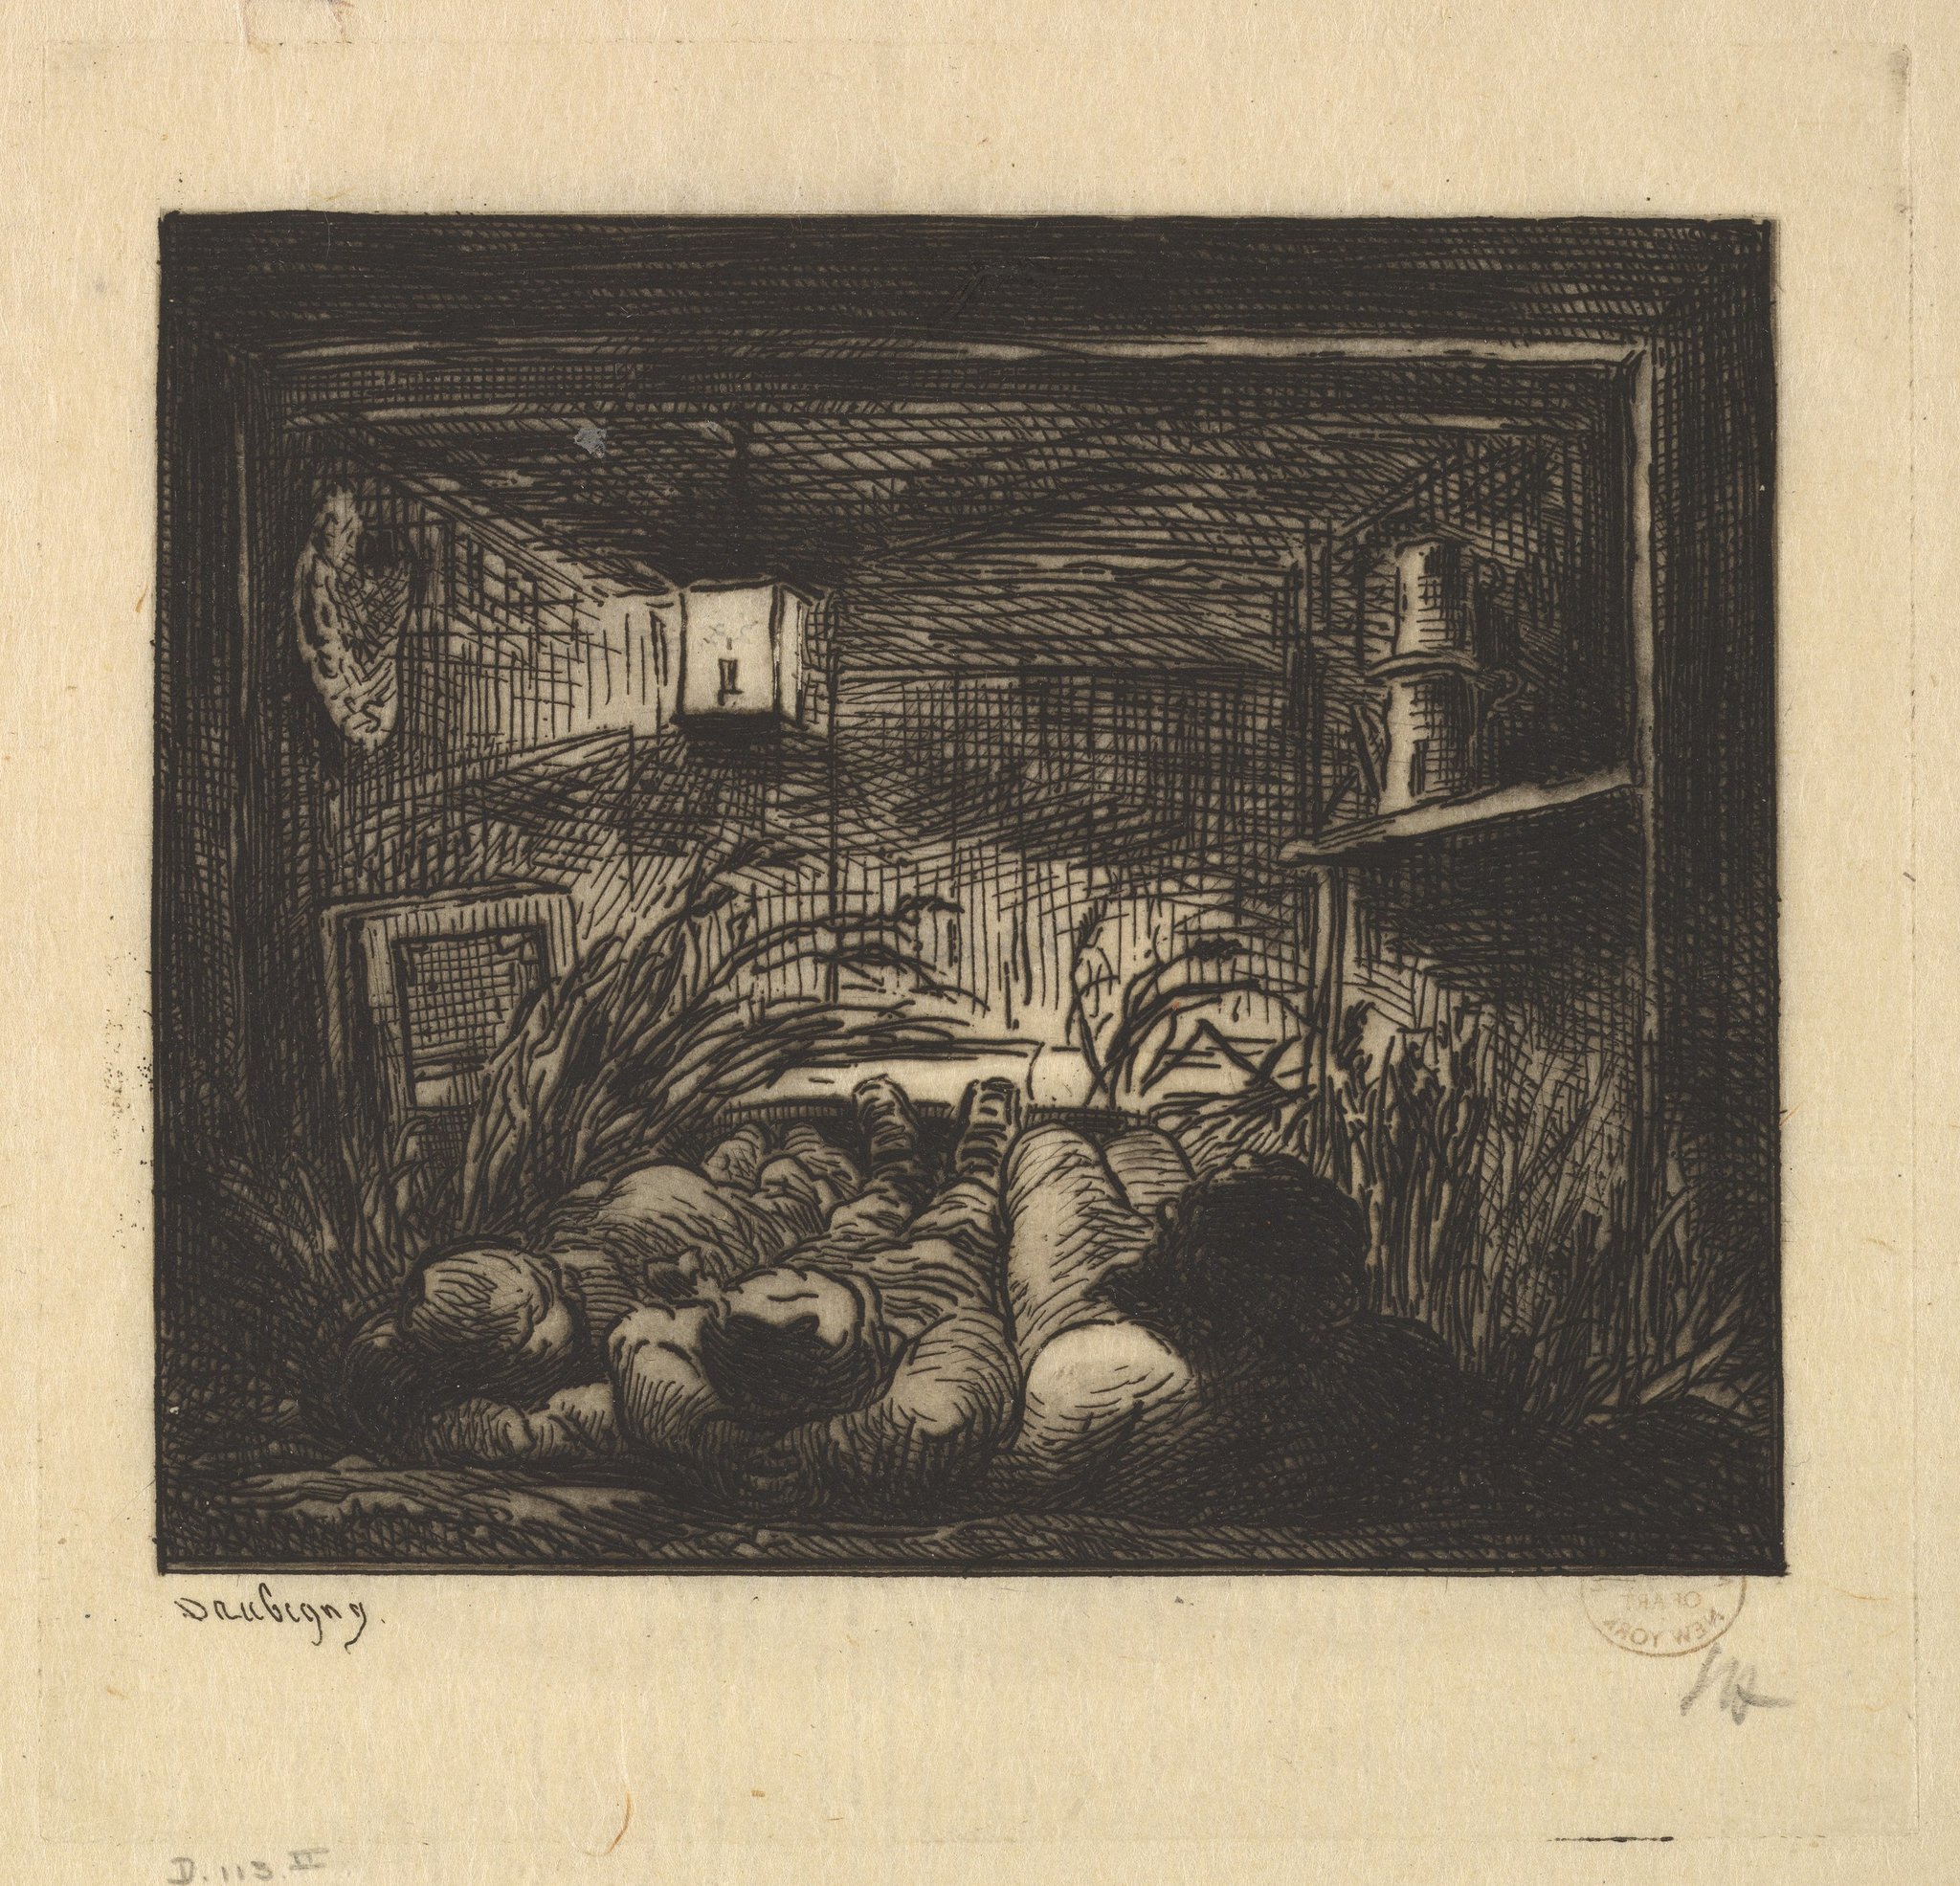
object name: print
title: Sleeping on Board the Boat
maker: charles-françois daubigny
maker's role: artist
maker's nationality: french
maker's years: 1817-1878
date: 1861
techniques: etching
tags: human figures,sleeping,boats